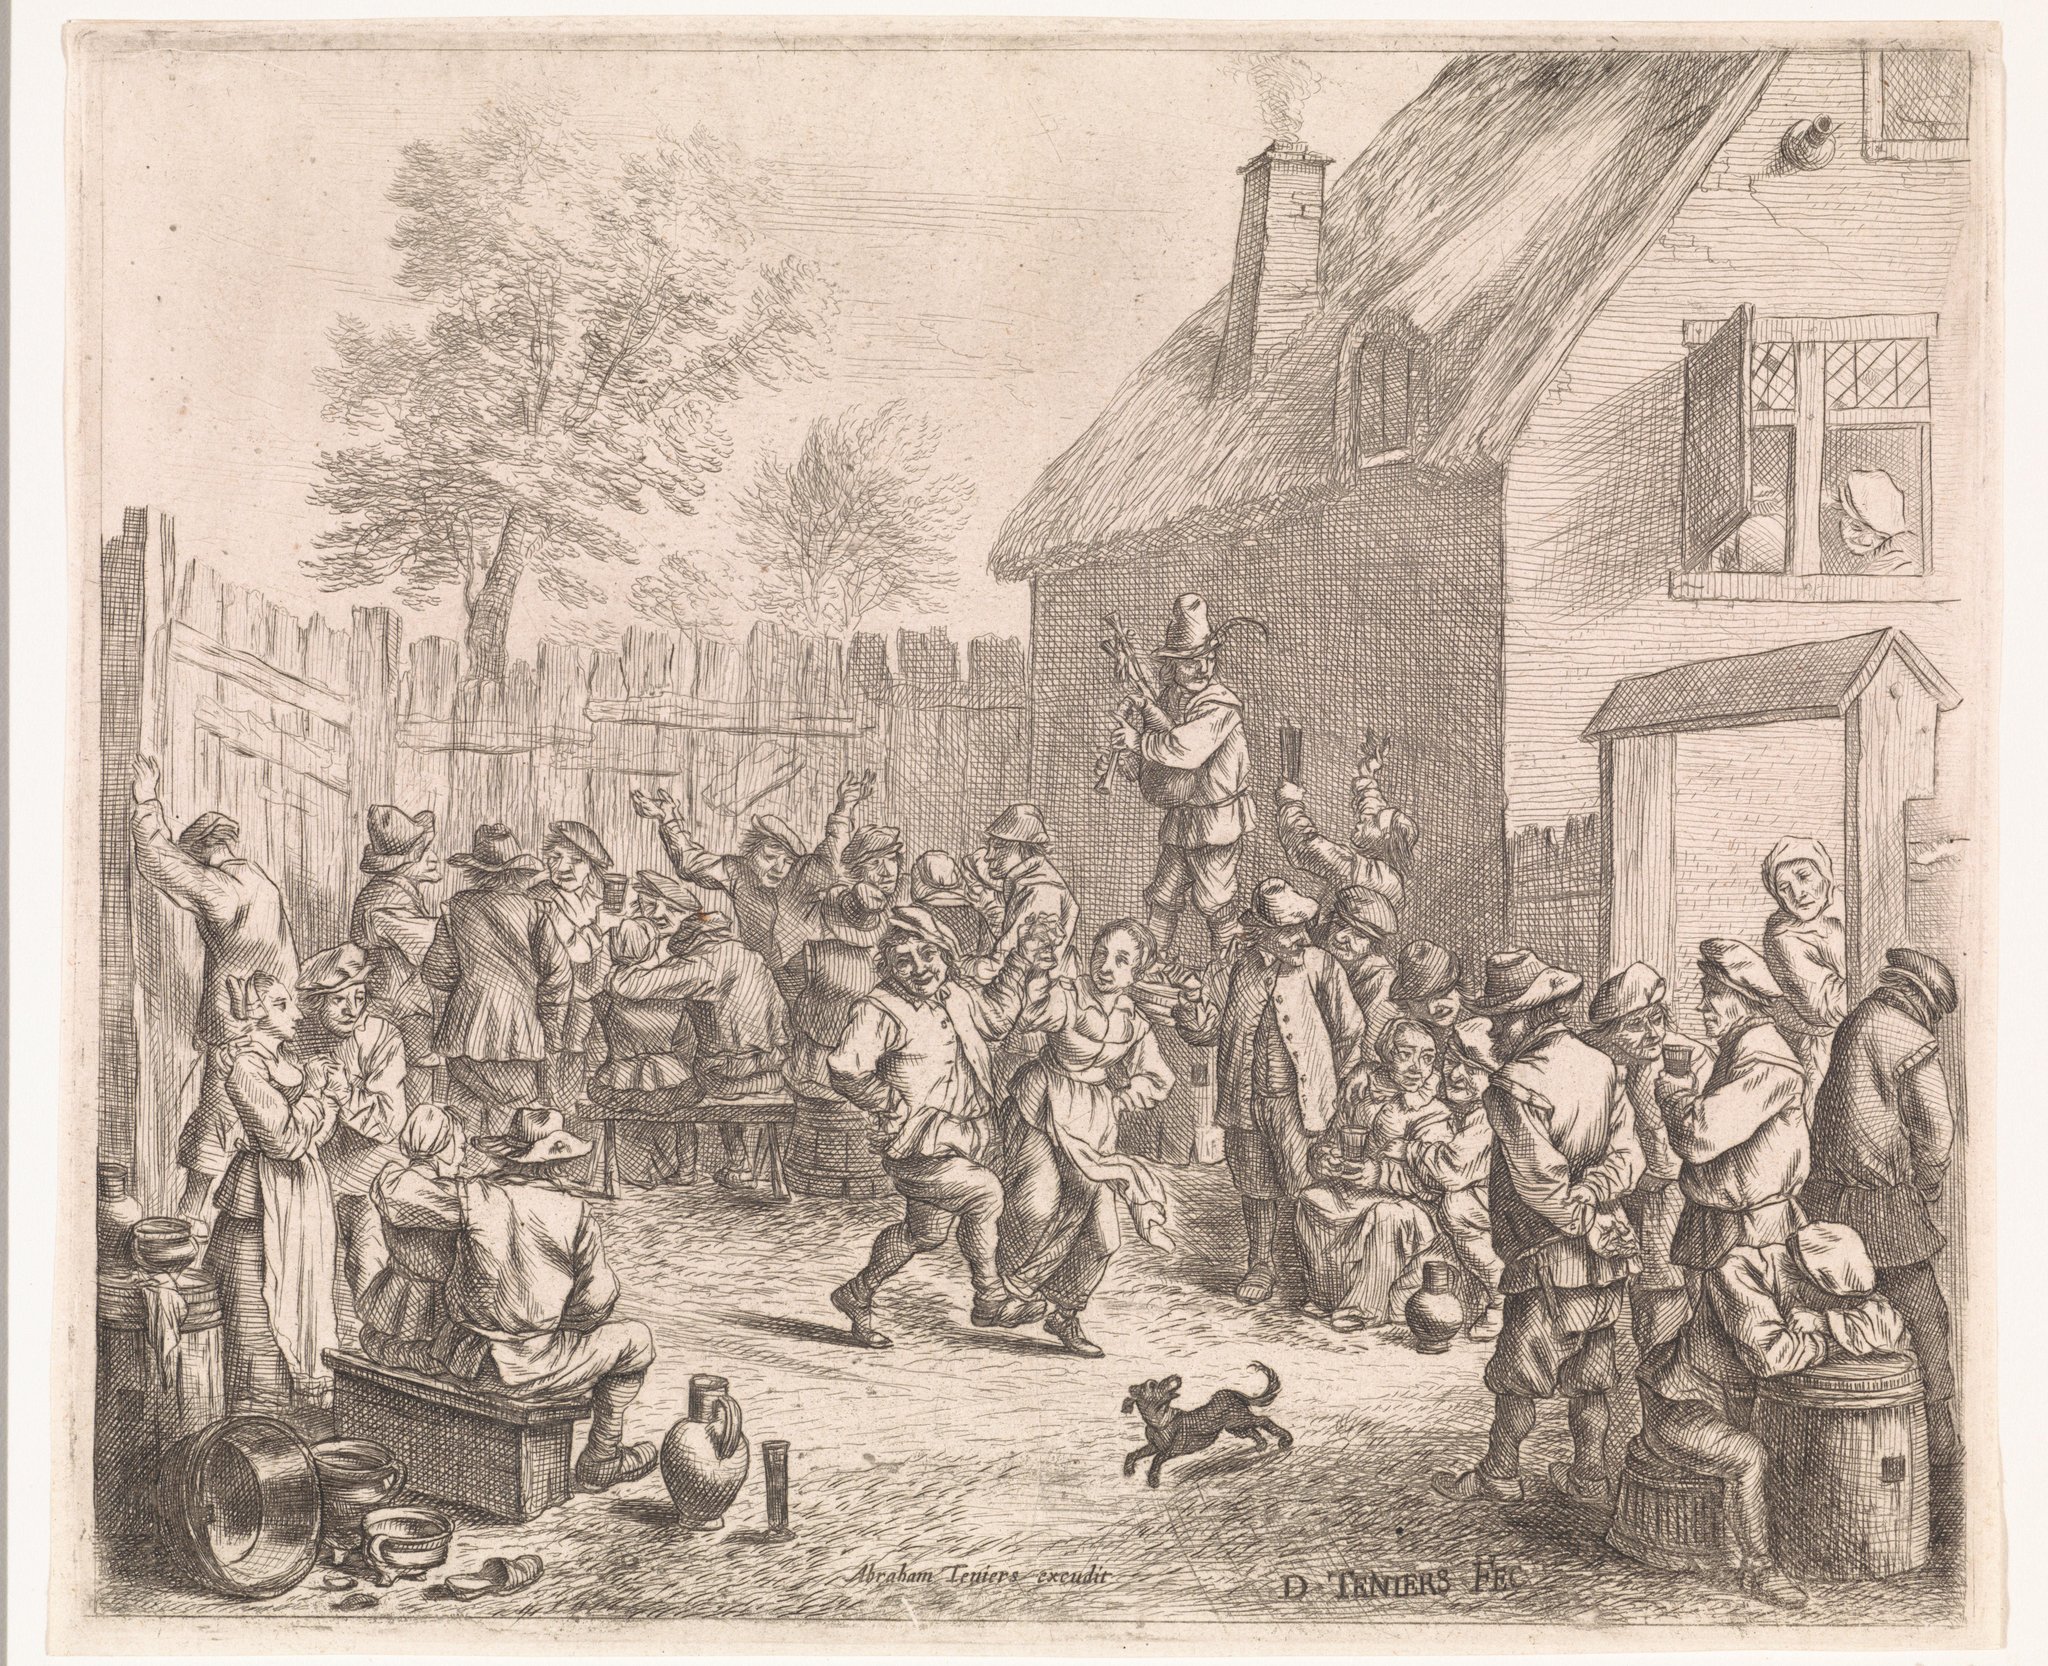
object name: print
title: Boerenkermis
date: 1639-1690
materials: paper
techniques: etching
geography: antwerp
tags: inn, coffee-house, public house, etc., one pair dancing; man and woman dancing as a couple, farmers, bagpipe, musette - cc - out of doors, drinking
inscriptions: collector's mark: Lugt 240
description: Een groep drinkende boeren naast een herberg. Een paar danst op de muziek van een doedelzakspeler.